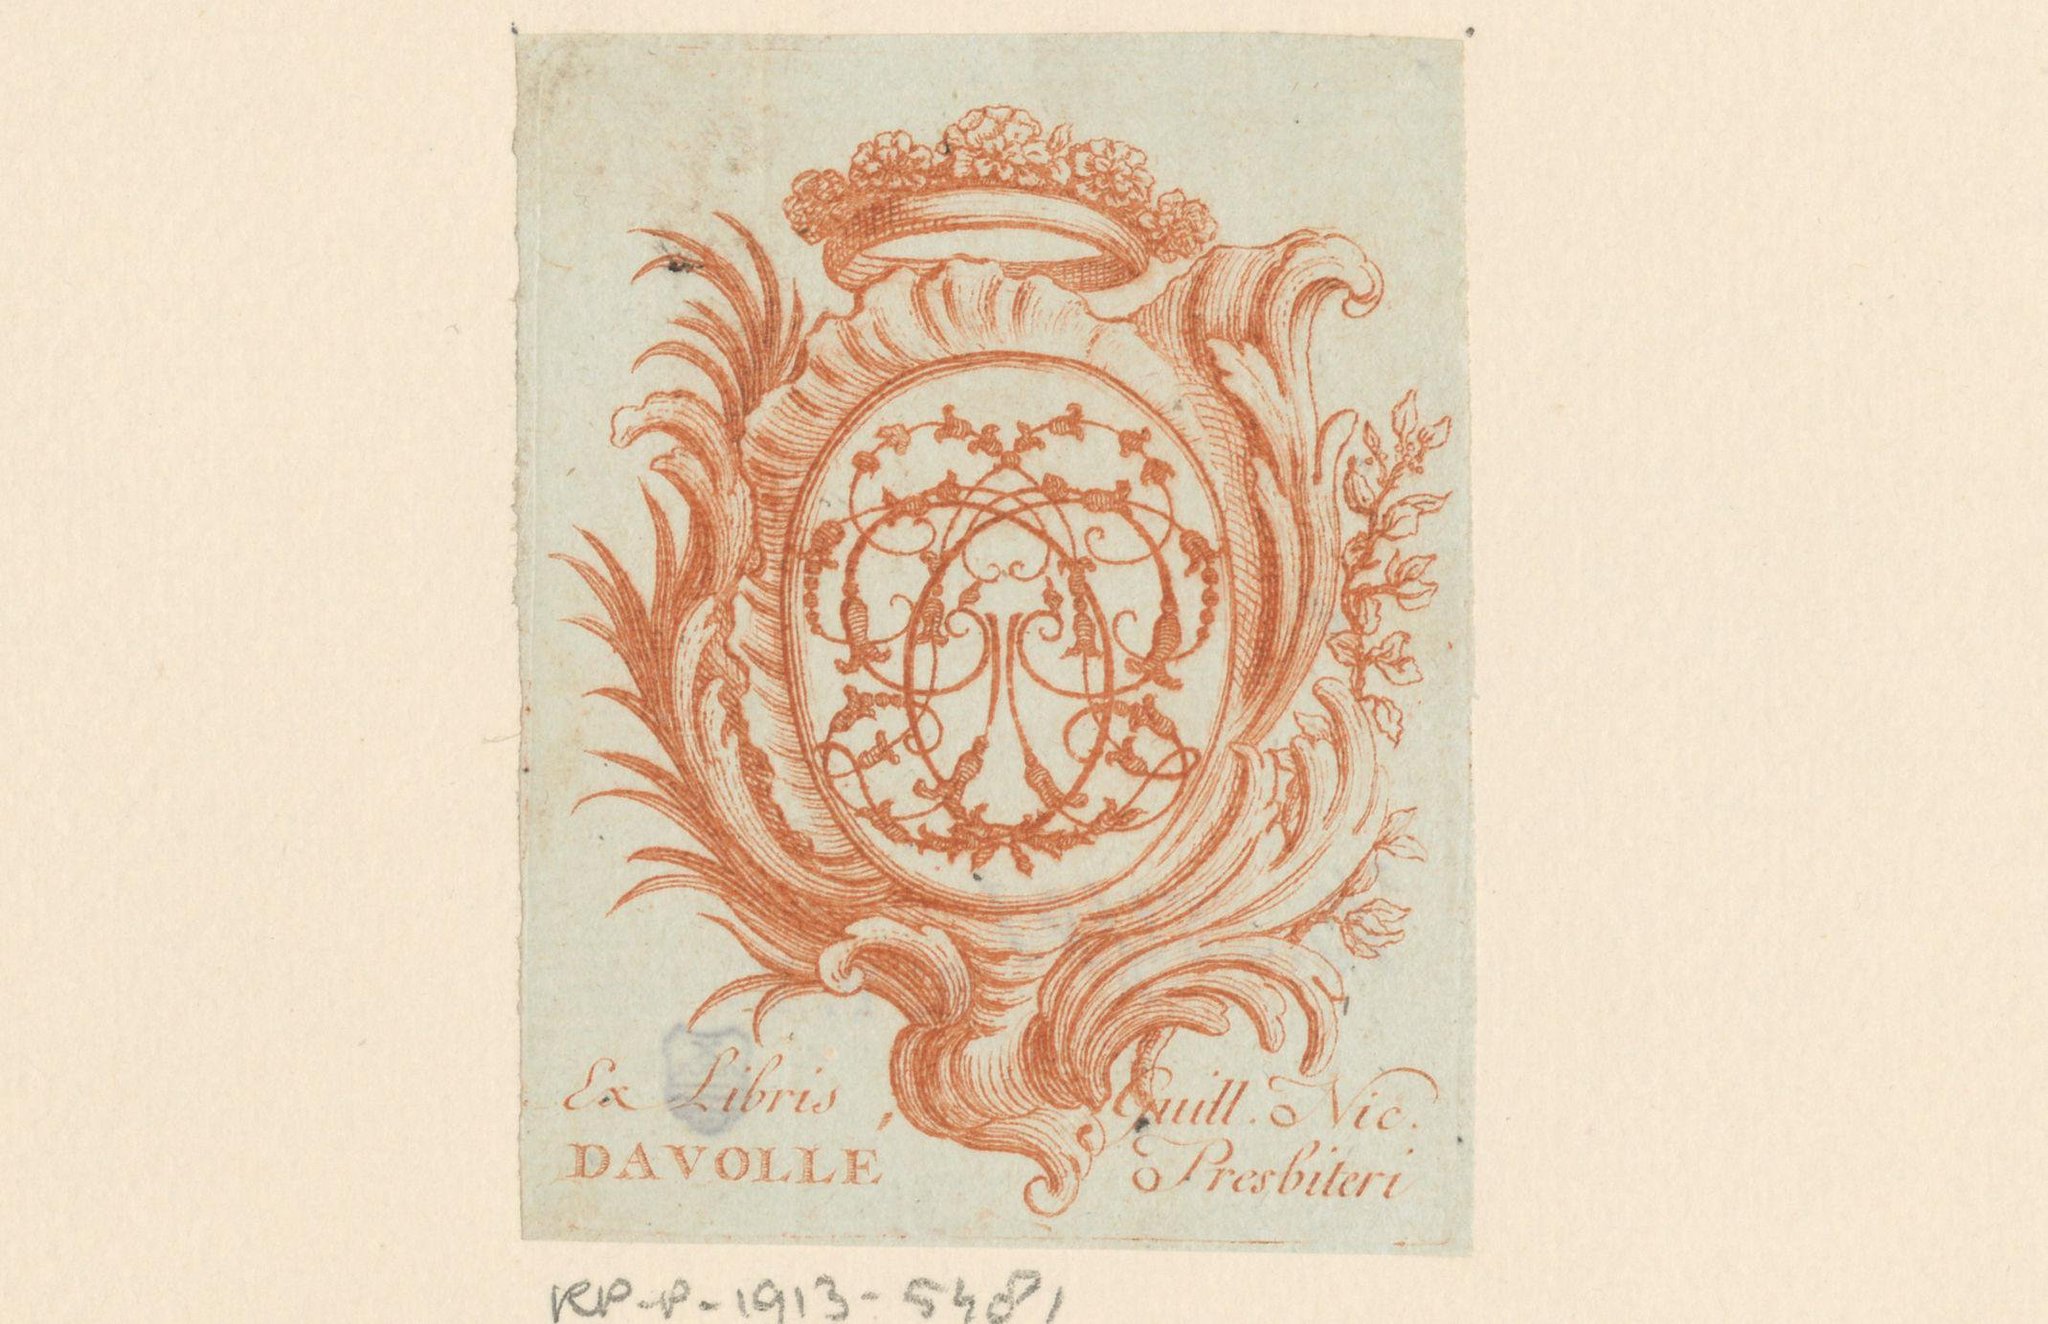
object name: bookplate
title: Ex libris van Guillaume Nicolas Davollé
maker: Anonymous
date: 1703-1740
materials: paper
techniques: etching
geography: france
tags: plants and herbs, armorial bearing, heraldry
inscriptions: collector's mark: Lugt 2760, collector's mark: Lugt 2233